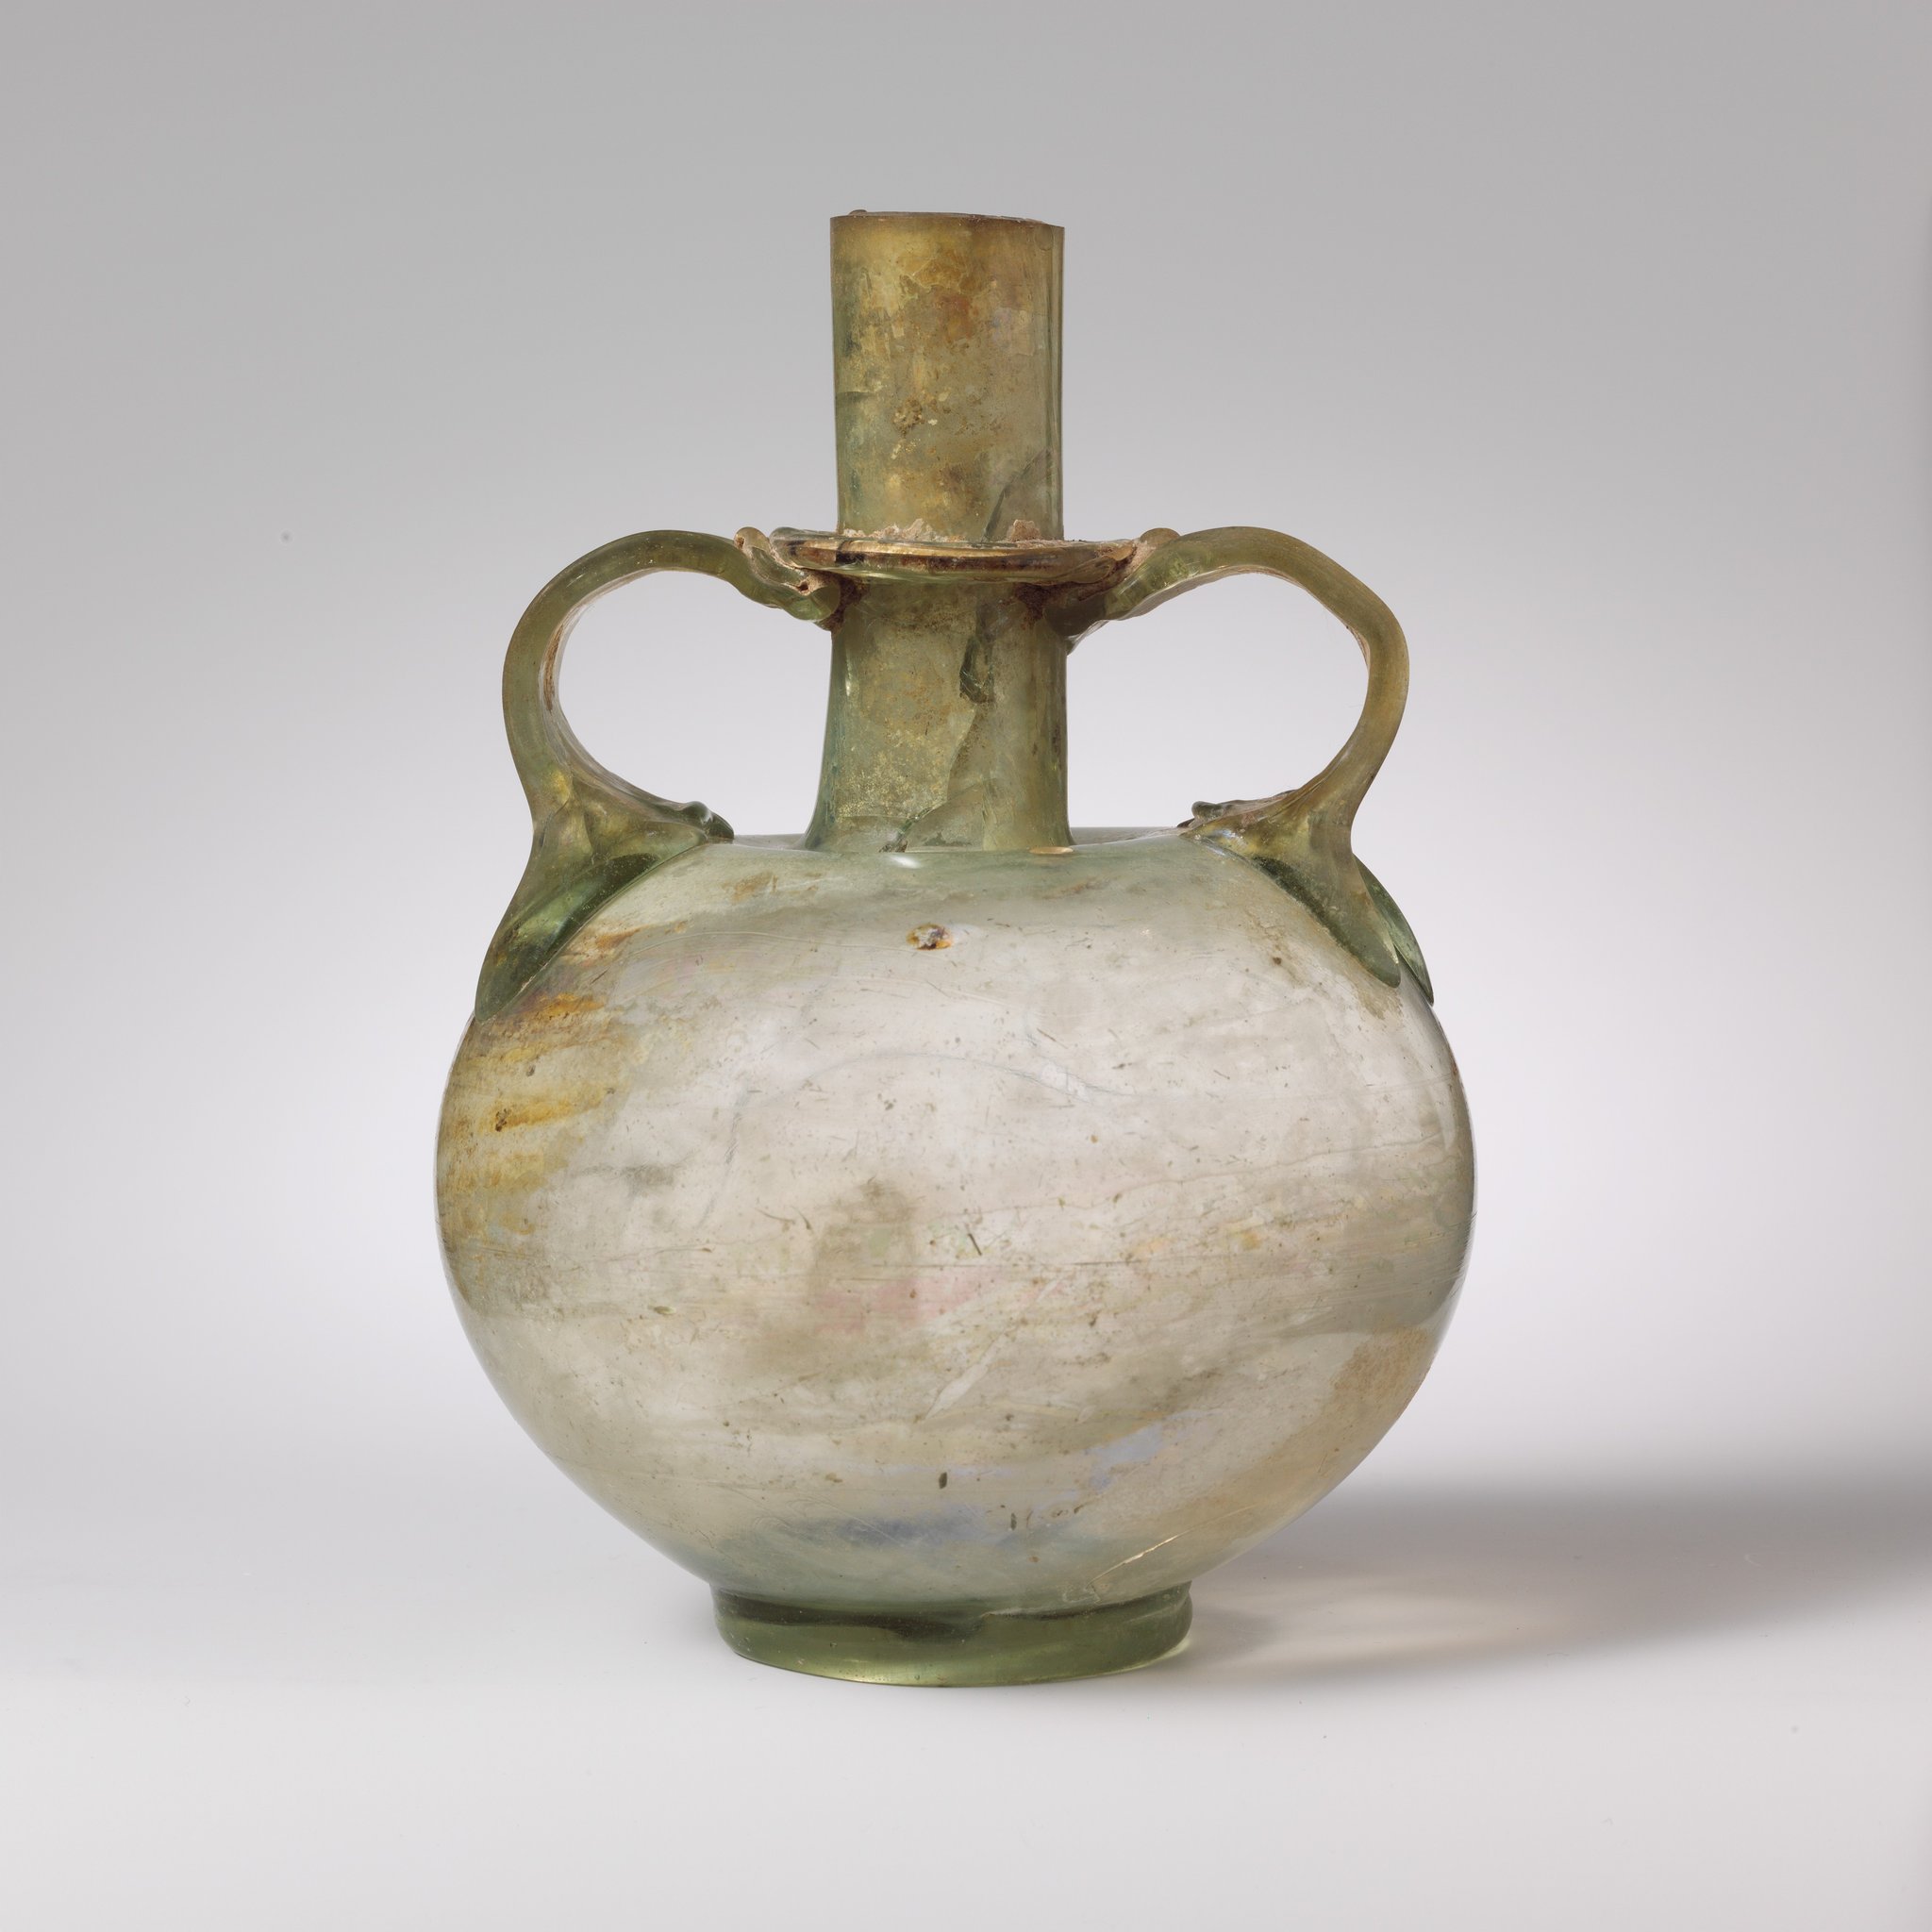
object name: bottle, two handled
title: Glass bottle with two handles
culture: roman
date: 301-400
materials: glass